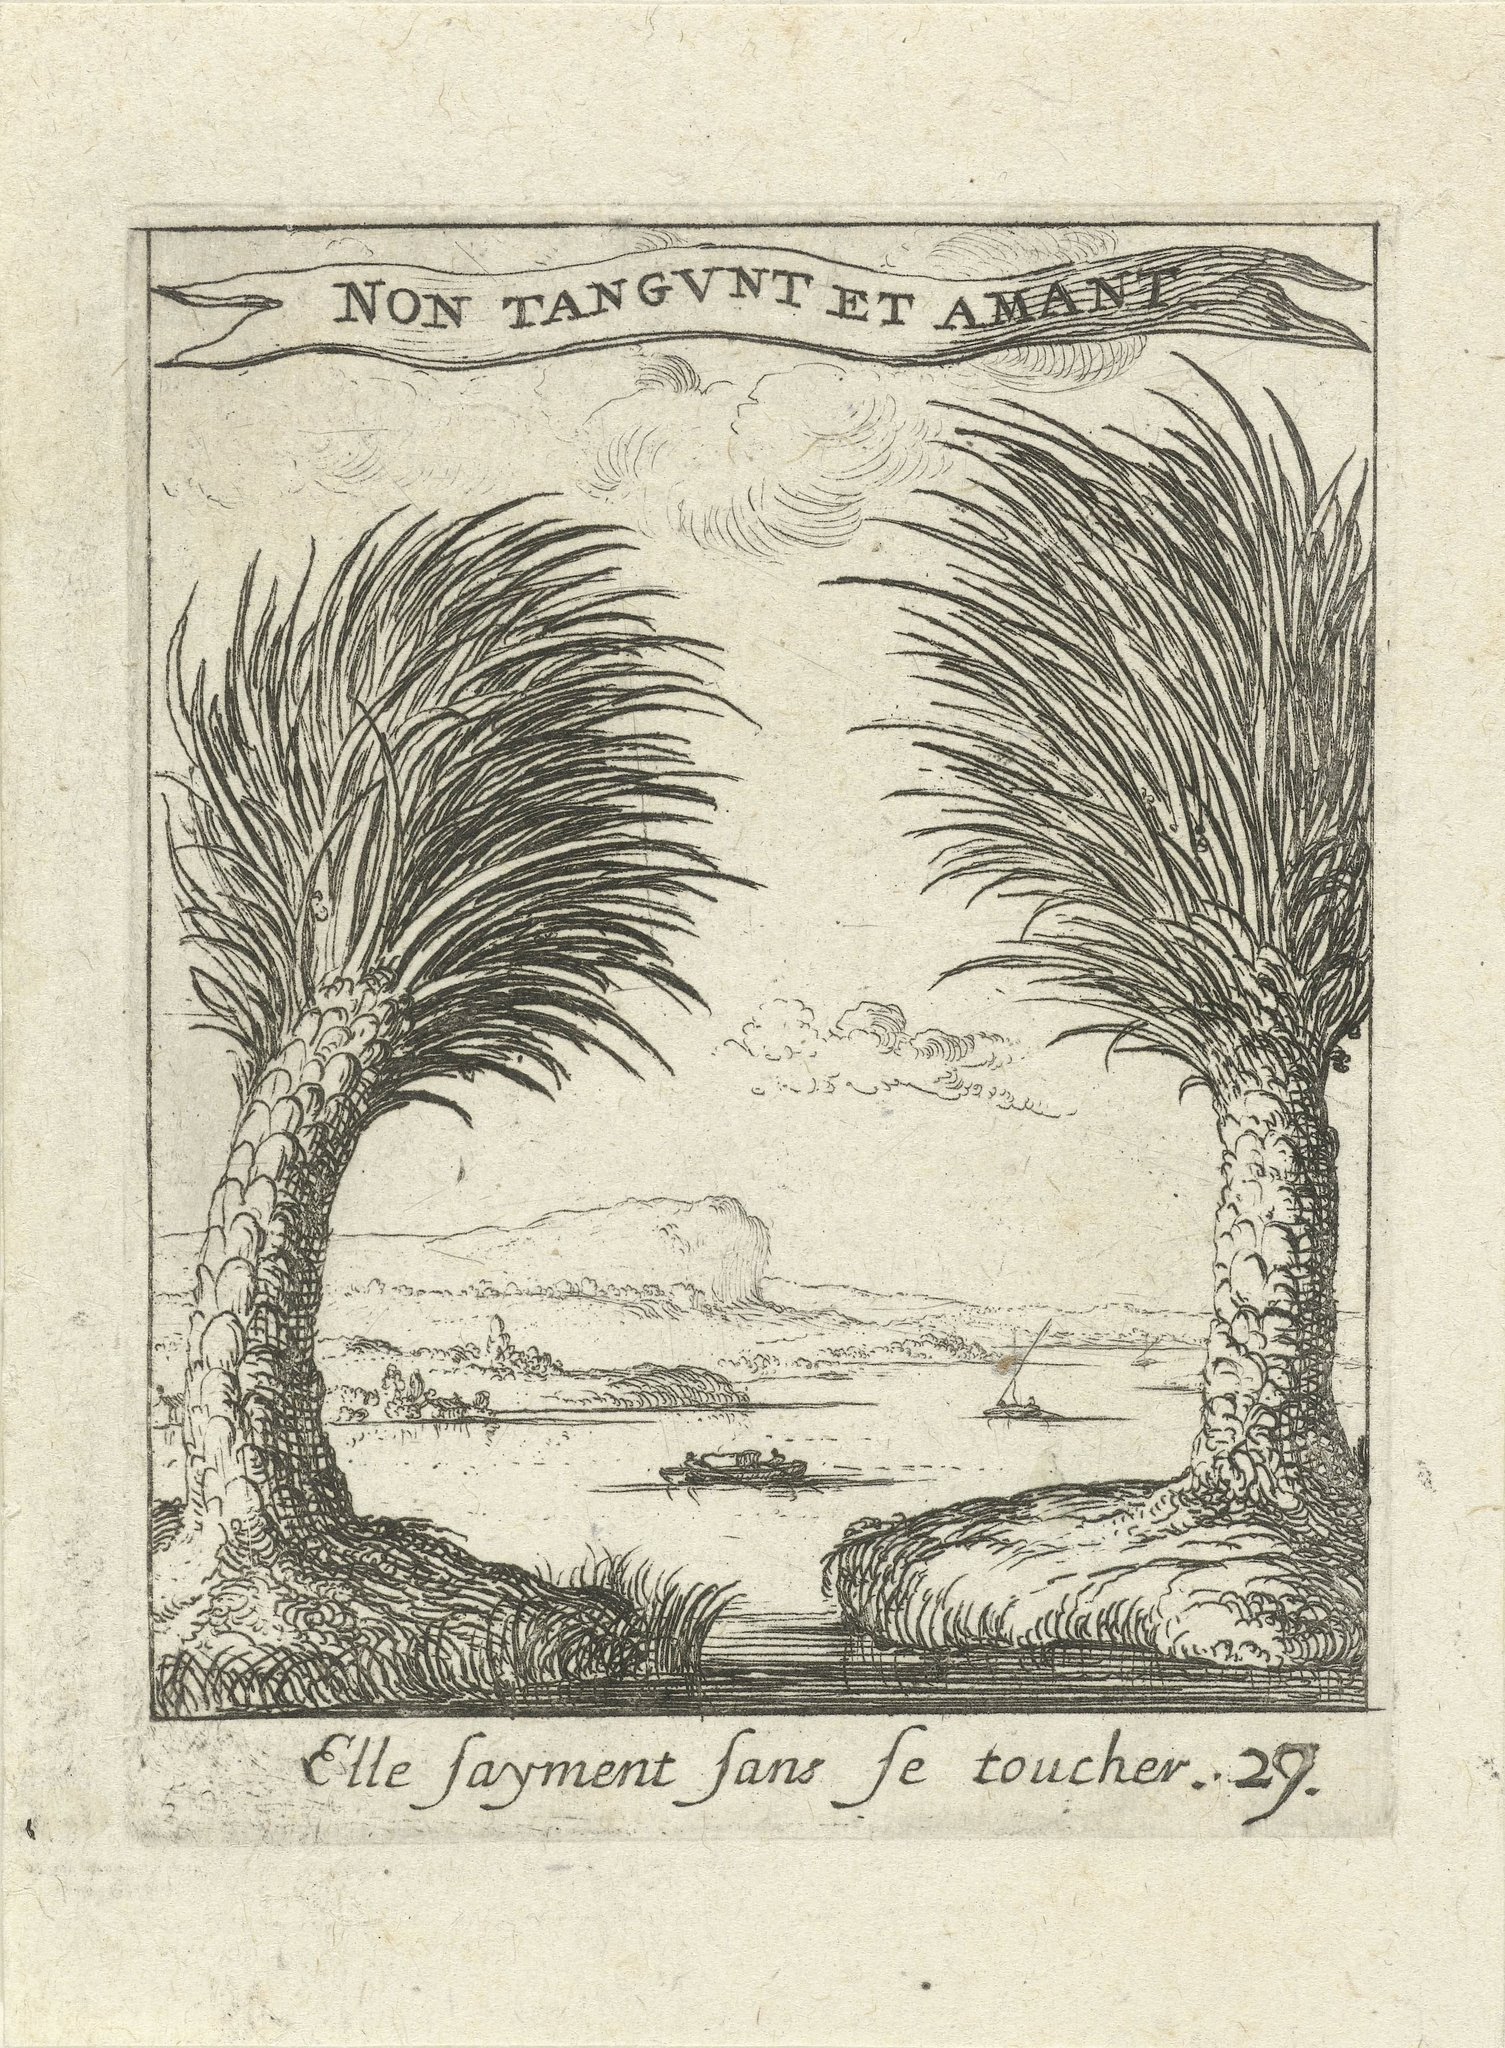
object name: print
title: Devises et emblesmes d'amovr moralisez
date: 1672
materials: paper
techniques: etching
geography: paris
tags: qualities of love: first series (+ emblematical representation of concept)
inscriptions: collector's mark: Lugt 2166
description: Een zeegezicht met op de voorgrond twee palmbomen. Op een banderol een devies in Latijn en een onderschrift in Frans, beide over de liefde.